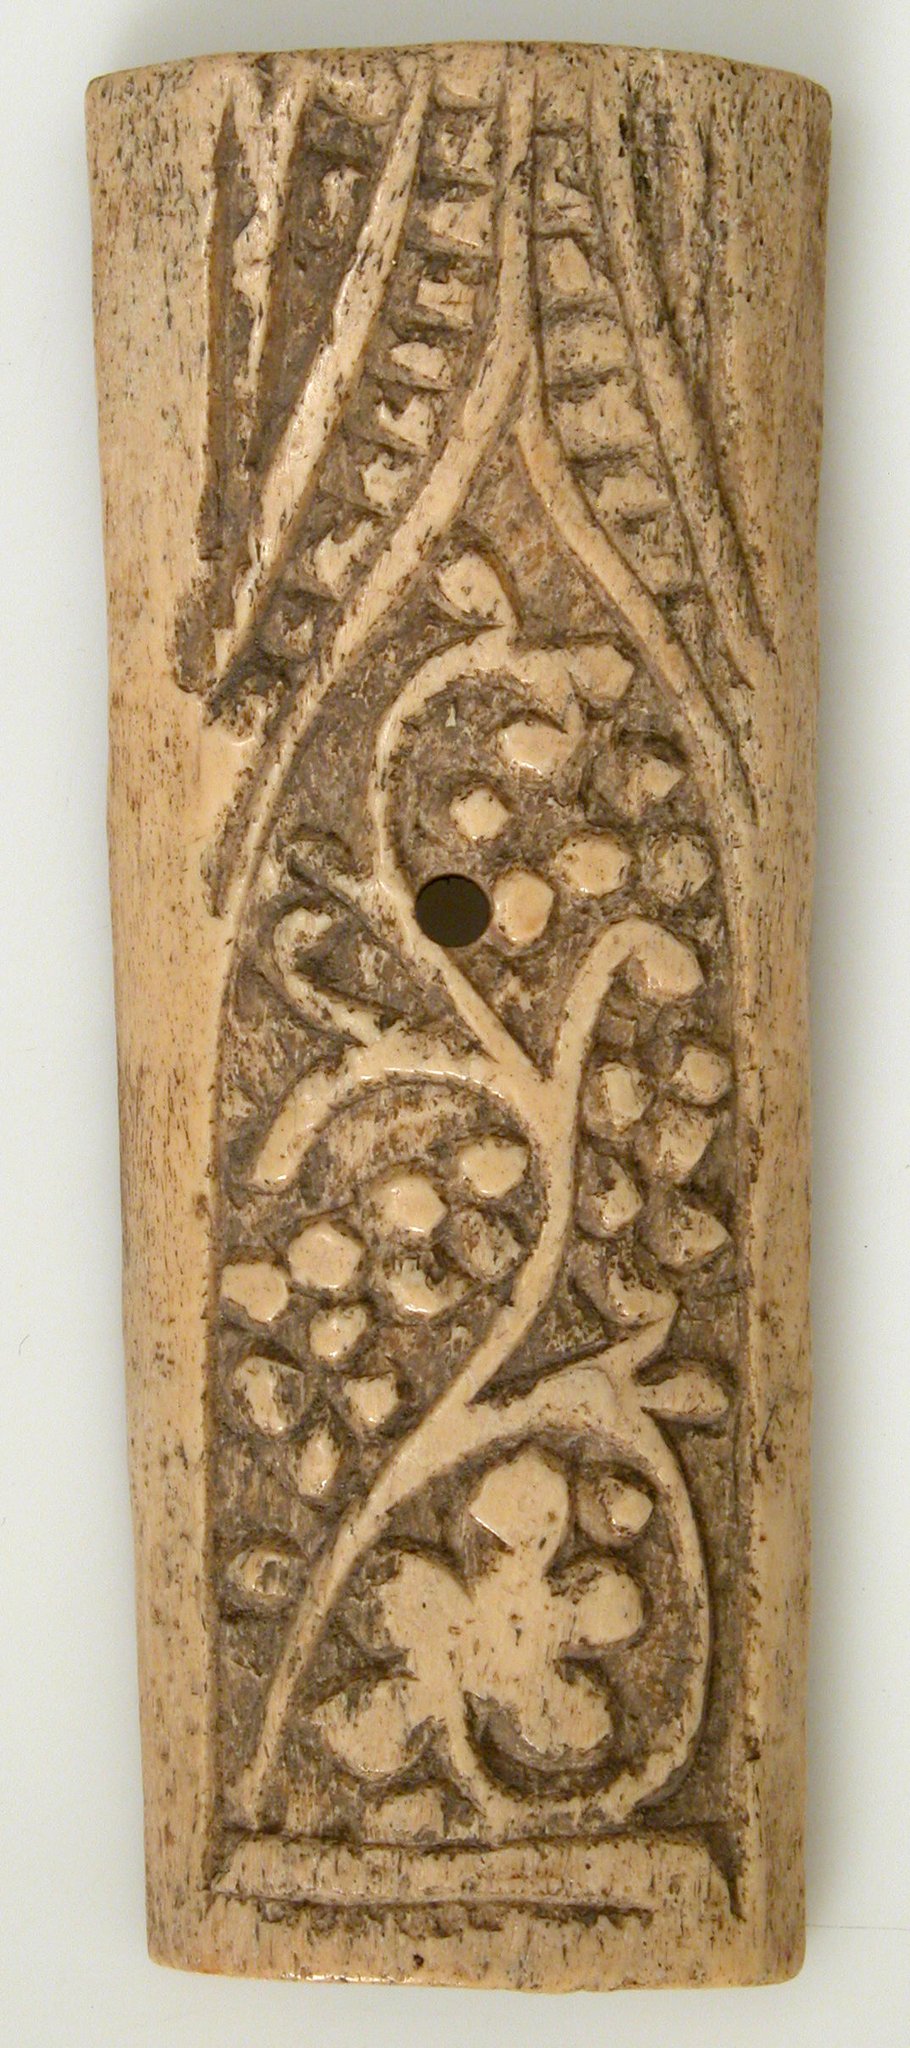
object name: plaque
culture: coptic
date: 301-700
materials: bone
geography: egypt